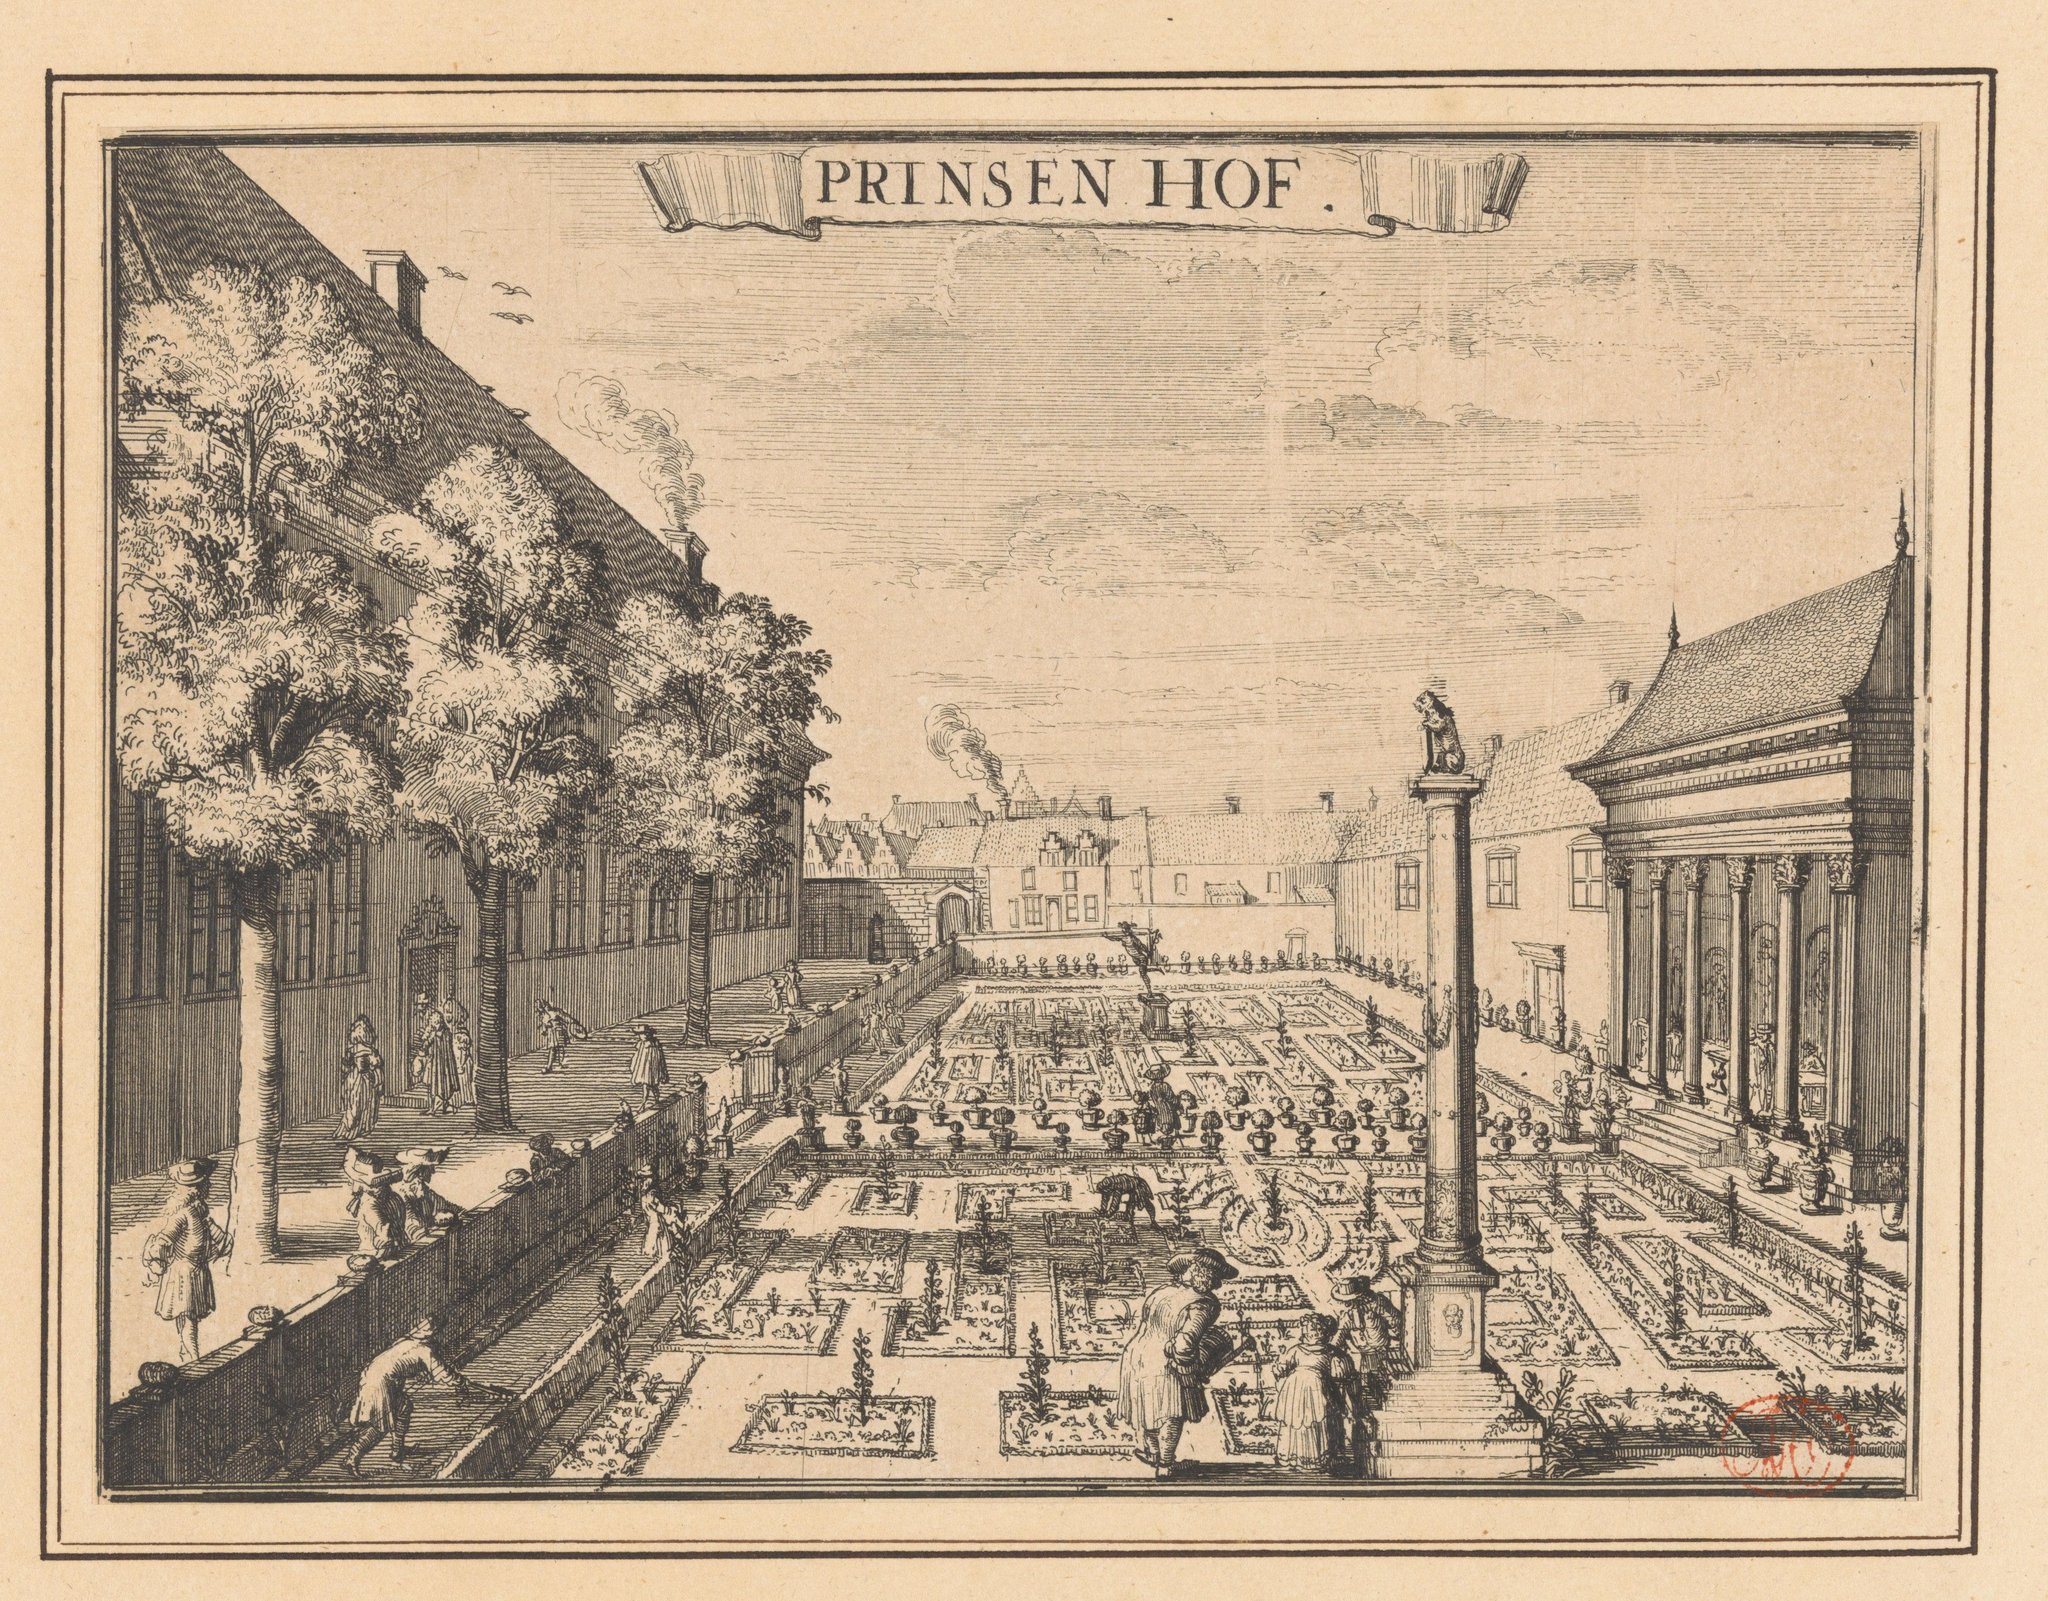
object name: print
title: Gezicht op het Prinsenhof te Haarlem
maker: romeyn de hooghe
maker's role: draughtsman, goldsmith, painter, print maker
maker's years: 1645-1708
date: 1688-1689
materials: paper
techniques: etching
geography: haarlem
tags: urban housing, garden, exterior ~ representation of a building, haarlem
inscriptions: collector's mark: Lugt 195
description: Gezicht op het Prinsenhof te Haarlem, met links enkele wandelaars en in de binnentuin enkele tuinmannen. Dit blad maakt oorspronkelijk deel uit van een omvangrijke prent met een grote plattegrond van Haarlem, omgeven door zeven wapenschilden, een profiel van de stad, gezichten op markante Haarlemse gebouwen en voorstellingen van belangrijke momenten uit de Haarlemse geschiedenis.